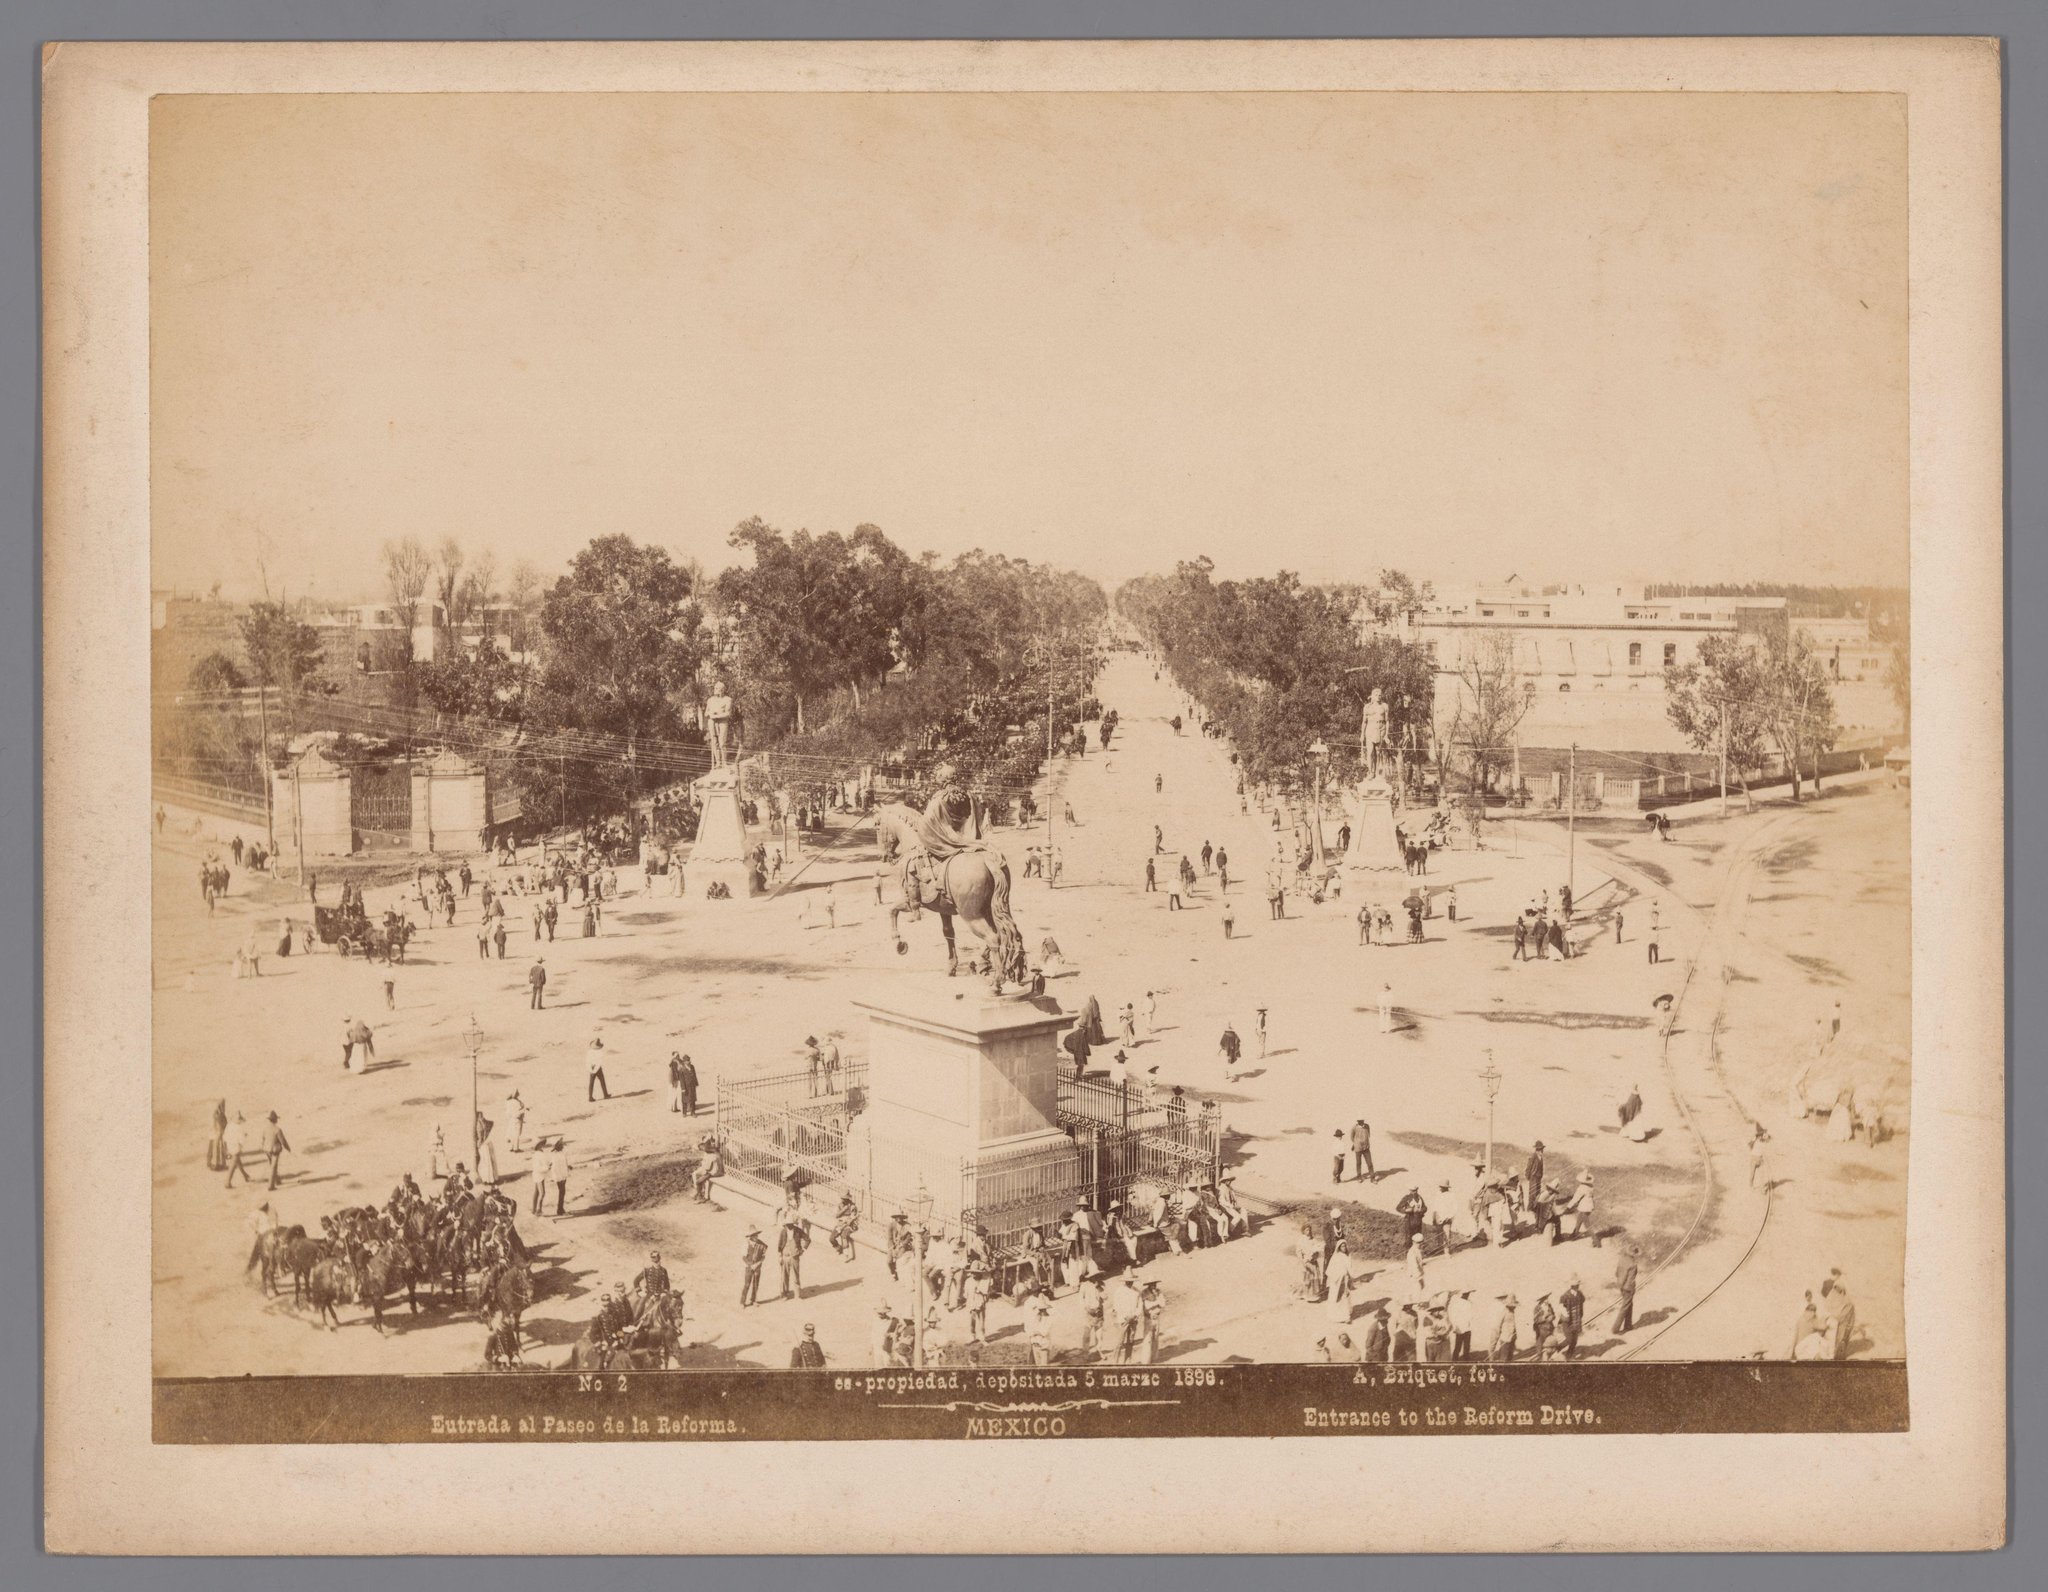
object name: photograph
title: Mexico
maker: abel briquet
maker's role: fotograaf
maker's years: 1833-1926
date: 1896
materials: cardboard, paper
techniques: albumen print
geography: mexico city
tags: square, place, circus, etc.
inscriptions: number: ‘No 2’, copyright notice: ‘es-propriedad, depositada 5 marzo 1896.’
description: Verkeerstplein met middenop een standbeeld met ruiter te paard.